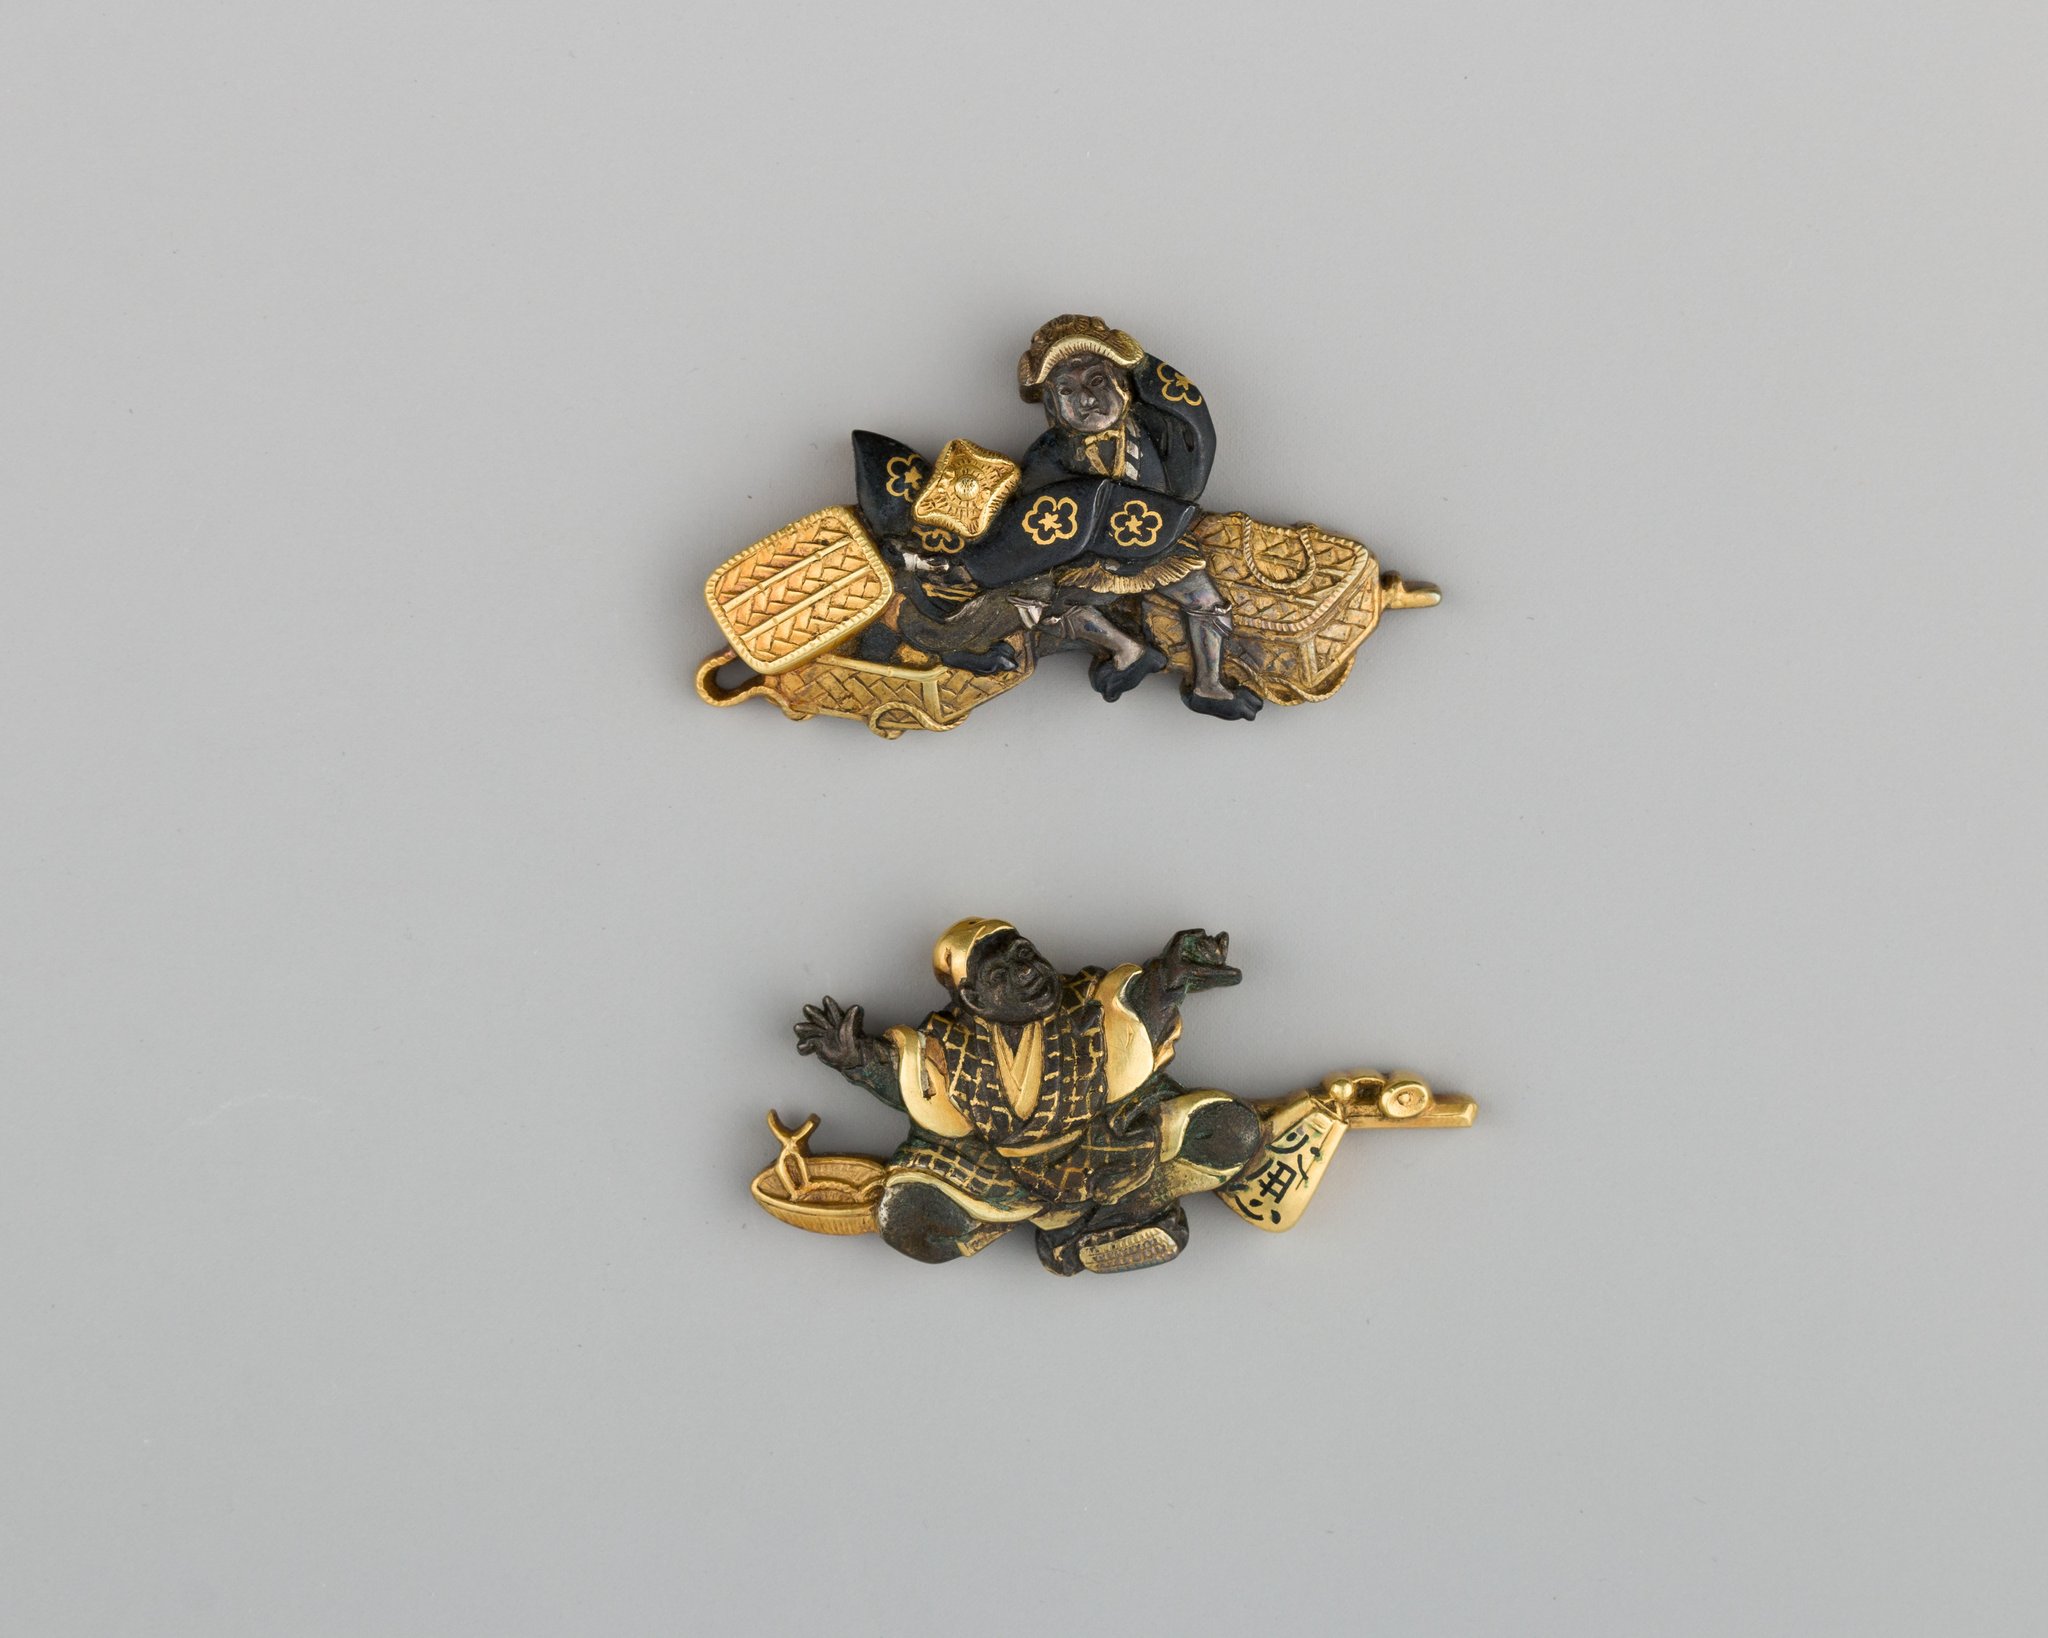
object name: pair of sword grip ornament menuki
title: Pair of Sword-Grip Ornaments (Menuki)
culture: japanese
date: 1701-1800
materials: gold alloy, silver alloy, gold, silver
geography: japan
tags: men